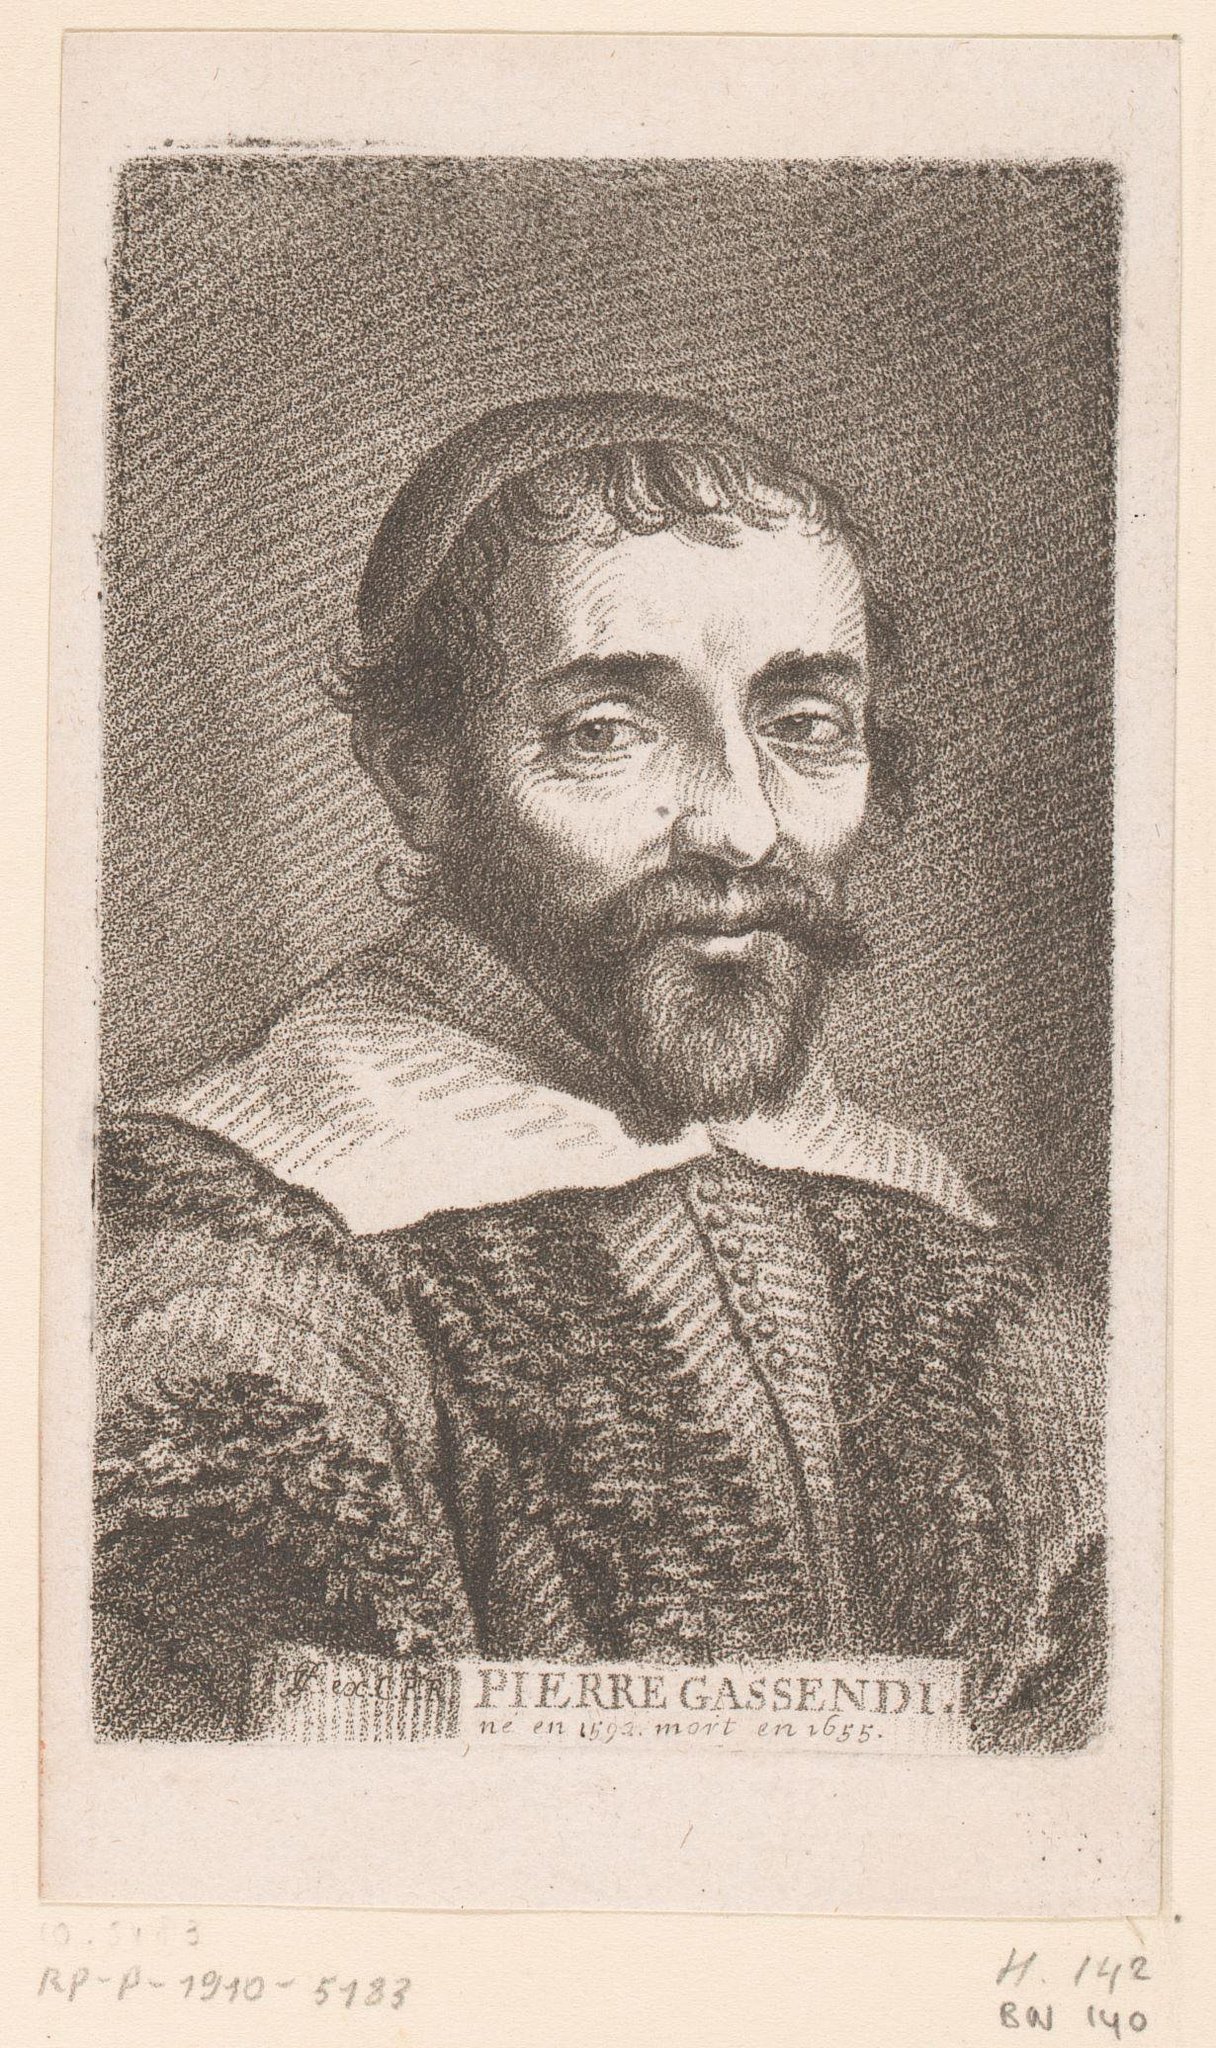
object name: print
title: Portret van Pierre Gassendi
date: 1760-1769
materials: paper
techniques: printmaking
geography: france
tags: paris, priest, scholar, philosopher, historical persons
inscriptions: collector's mark: Lugt 2228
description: Prent uit: Saverien, Alexandre. L'Histoire des Philosophes modernes, avec leur portrait gravé dans le goût du crayon, d'apres les desseins des plus grands peintres. Parijs: Jean Charles François, 1760-1761, dl. 3